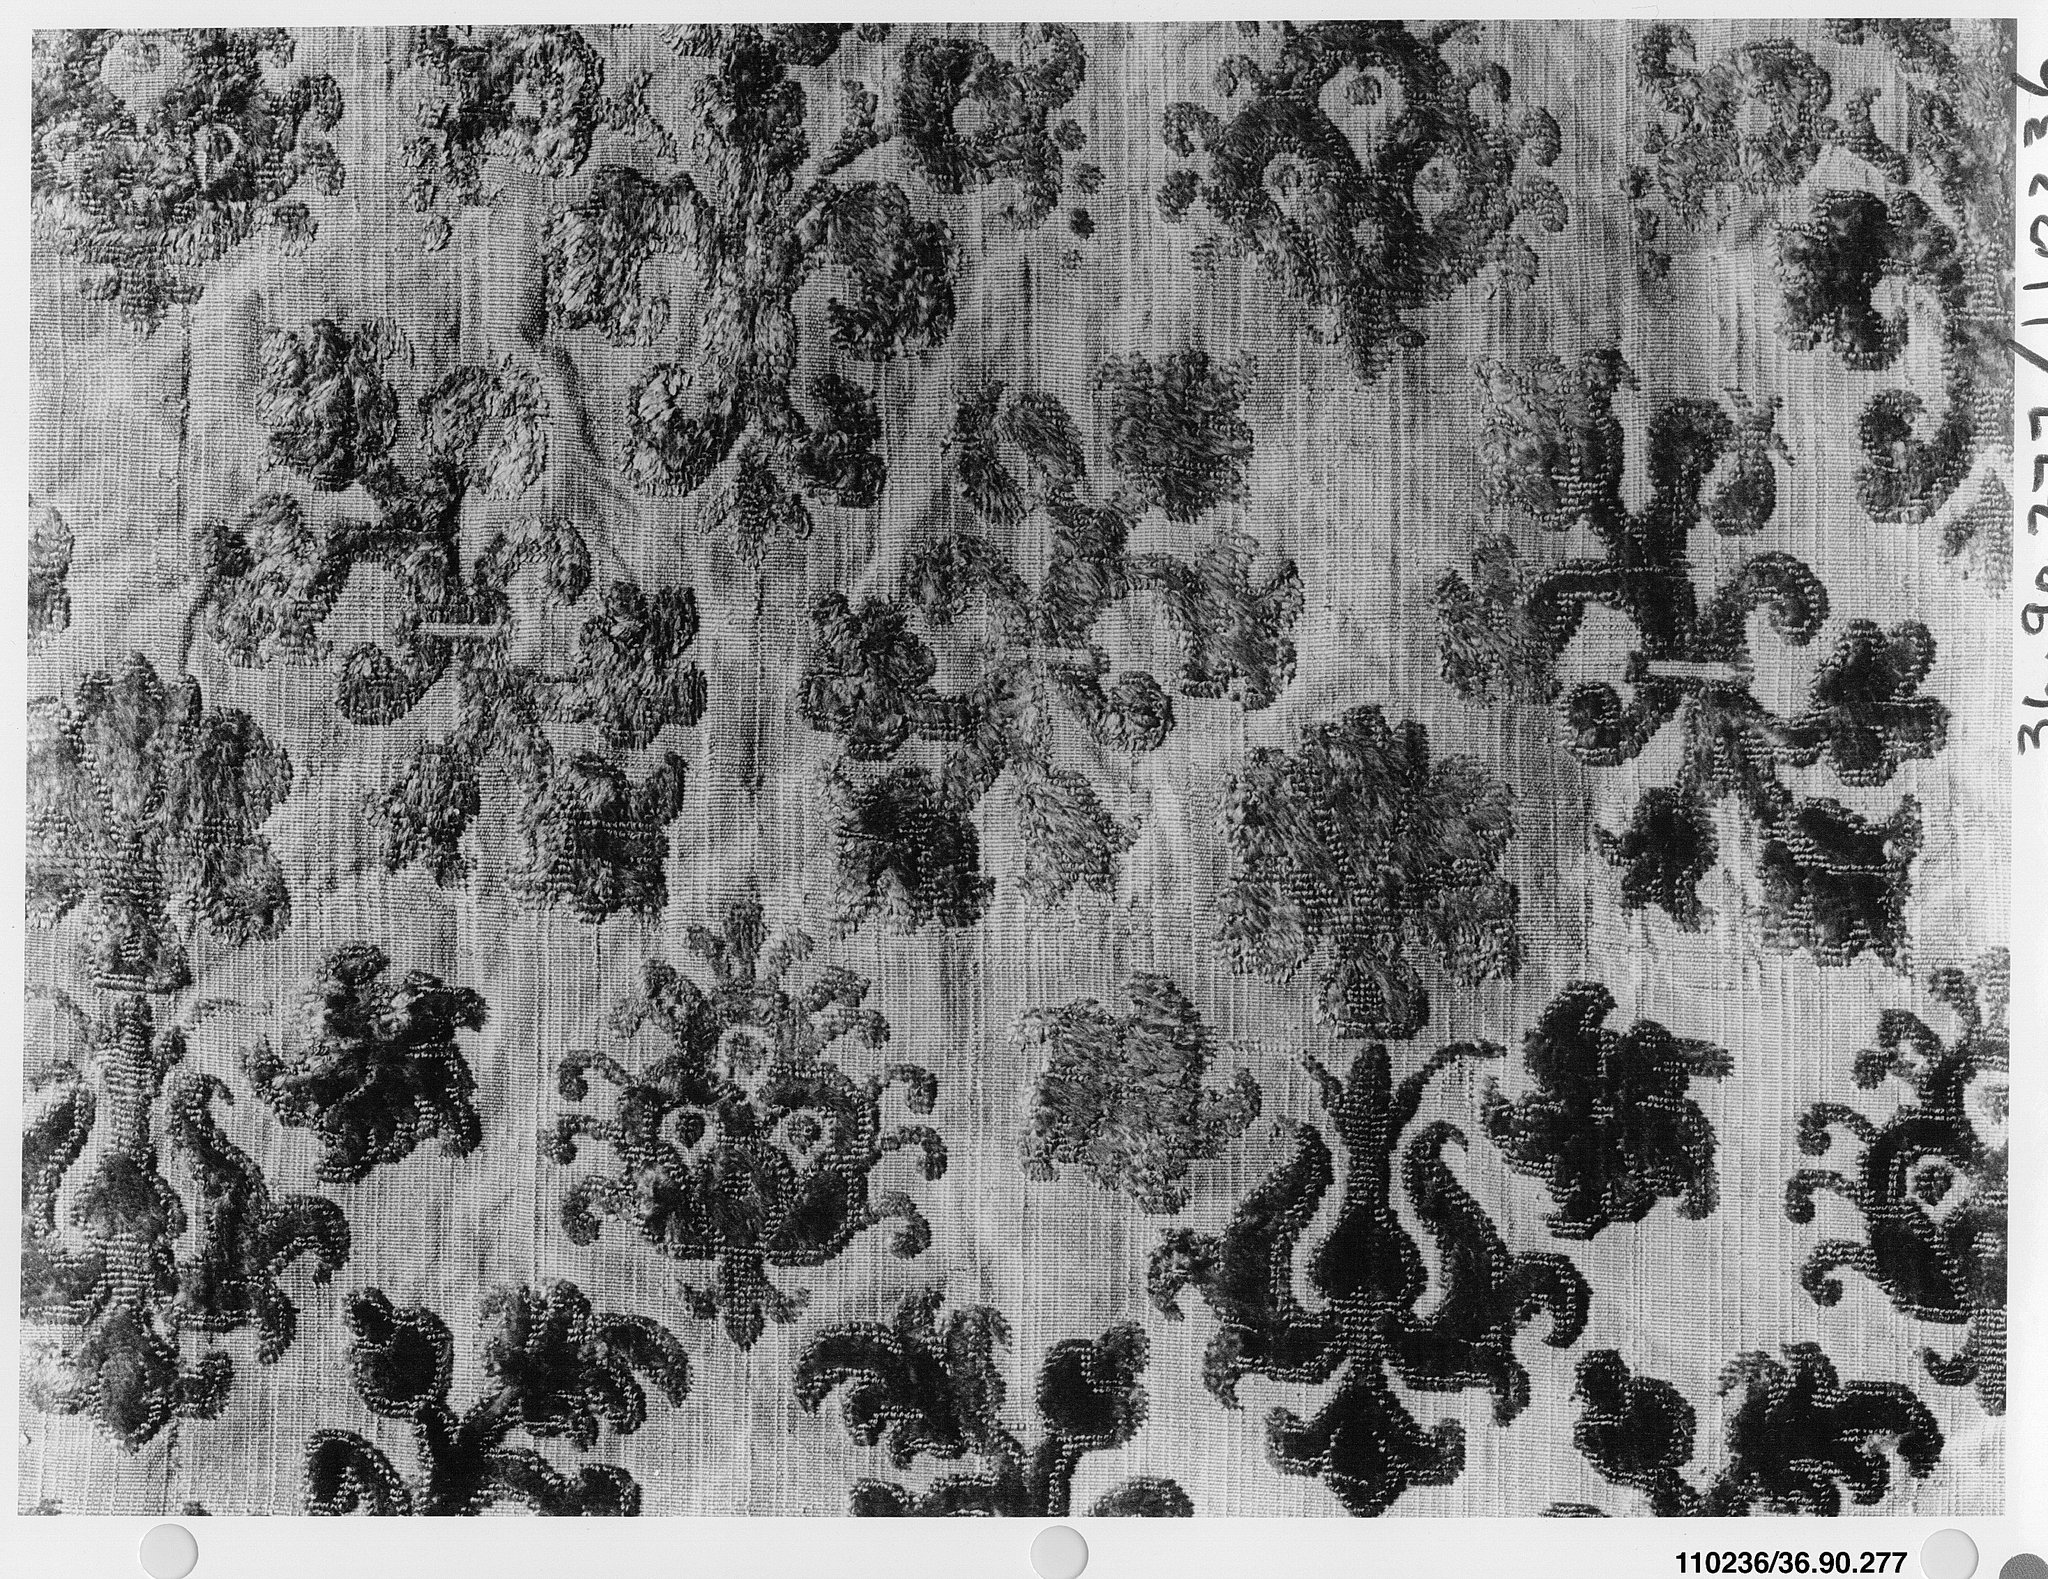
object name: piece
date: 1501-1700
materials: silk